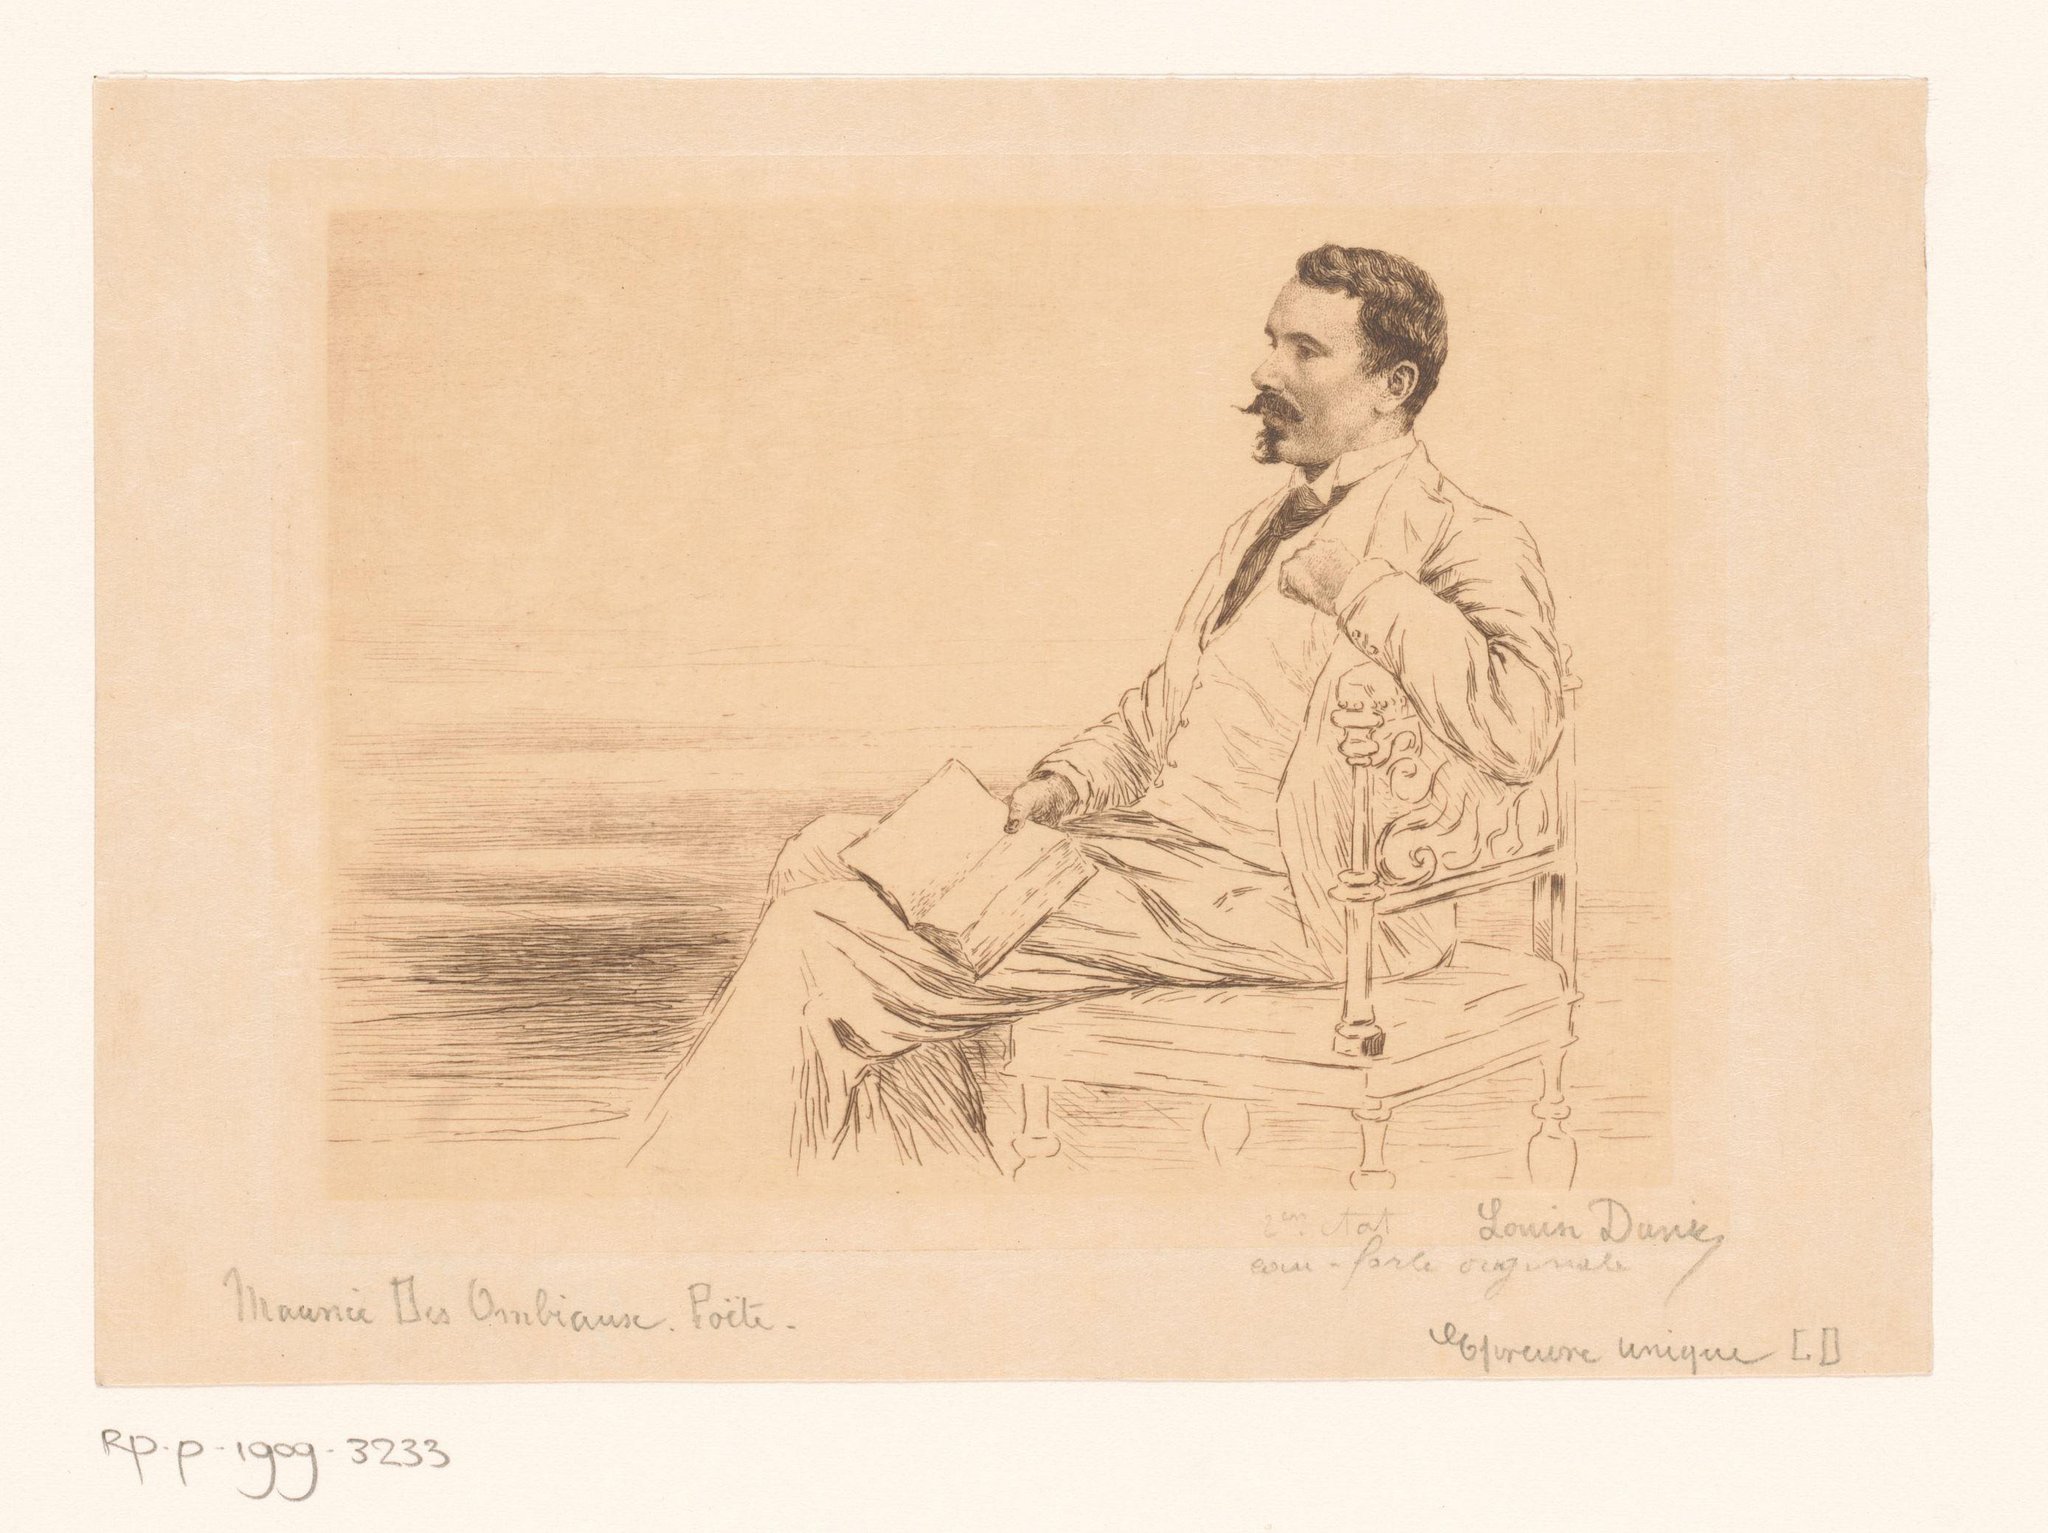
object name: print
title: Portret van Maurice des Ombiaux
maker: louise danse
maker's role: painter, print maker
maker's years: 1867-1948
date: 1877-1909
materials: paper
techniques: etching, intaglio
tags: paris, maurice des ombiaux, portrait of a writer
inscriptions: collector's mark: Lugt 2228, annotation: ‘2m etat; eau-forte originale; épreuve unique; Maurice des Ombiaux - Poëte’